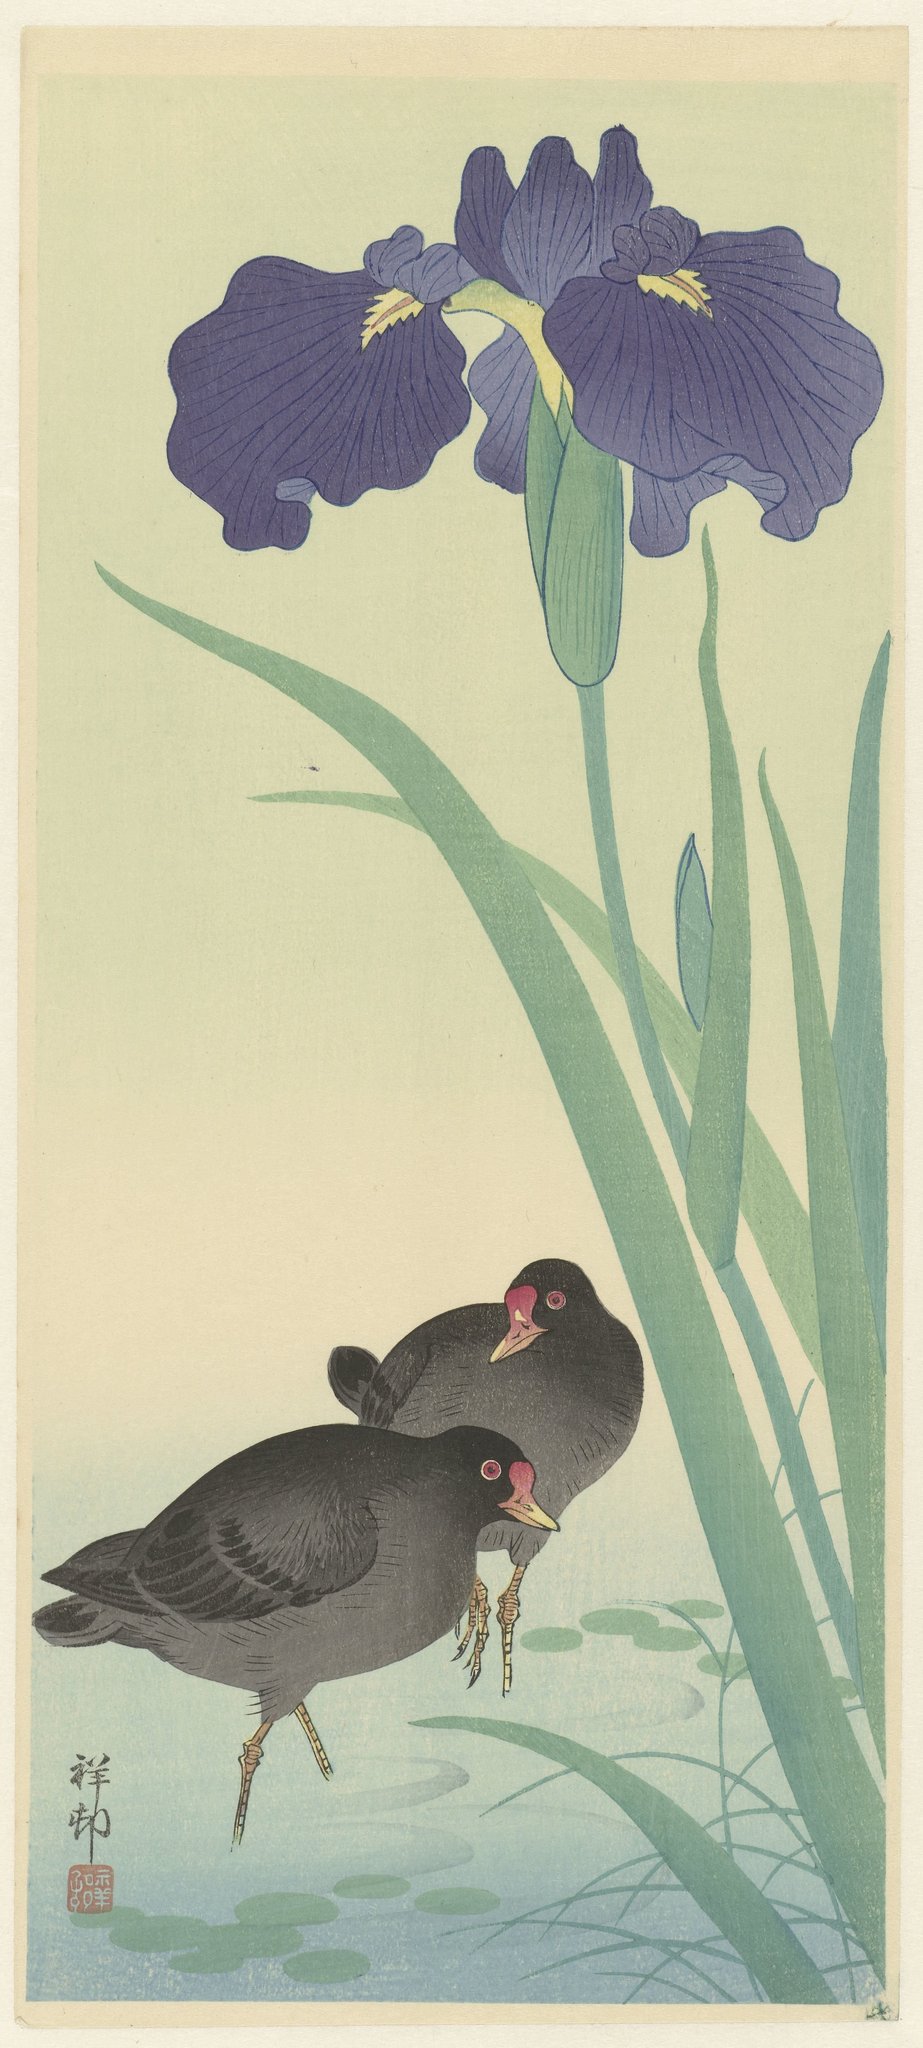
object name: print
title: Waterhoentjes en iris.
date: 1925-1936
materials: paper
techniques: woodcut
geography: japan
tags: flowers: iris, water-birds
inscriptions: collector's mark: Lugt 2228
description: Twee waterhoentjes in ondiep water met paarse iris.